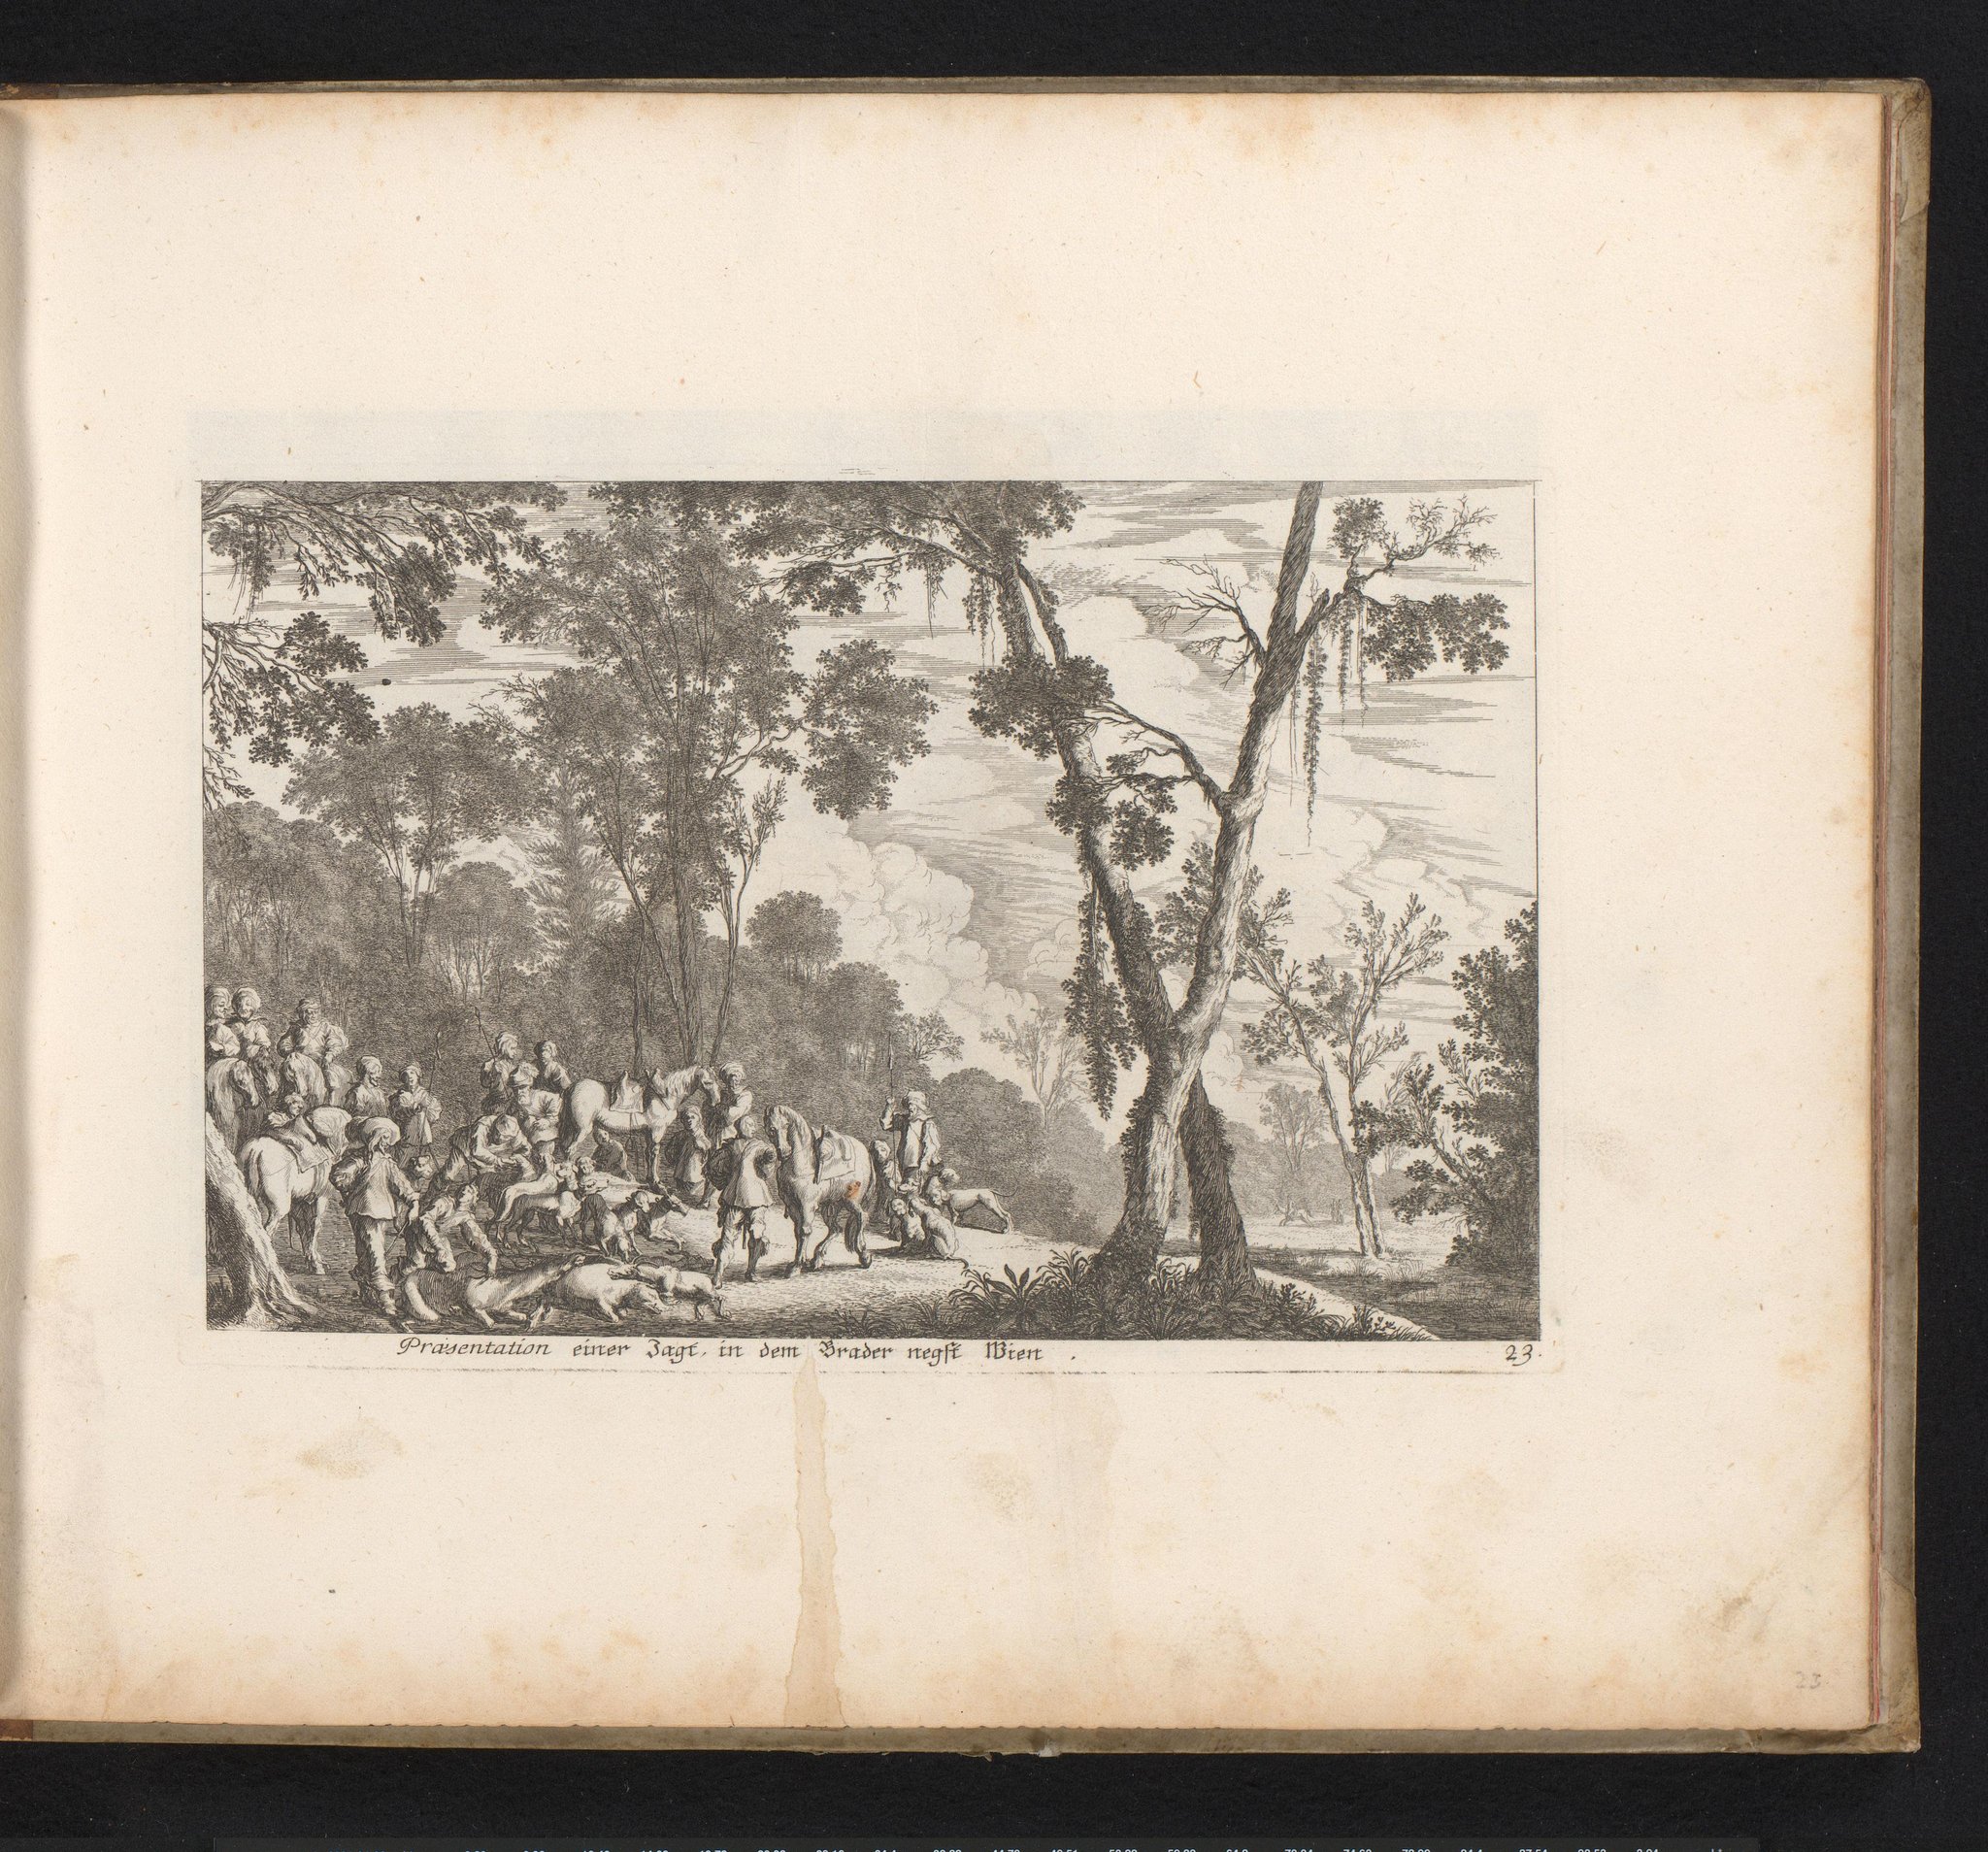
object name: print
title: Jagers in een bos bij Wenen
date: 1670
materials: paper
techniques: etching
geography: augsburg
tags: fringe, edge of the wood, hunters resting during the hunt, vienna state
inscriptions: collector's mark: Lugt 2228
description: Tekst in het Duits in de ondermarge. Rechtsonder genummerd: 23. Prent maakt deel uit van een album.